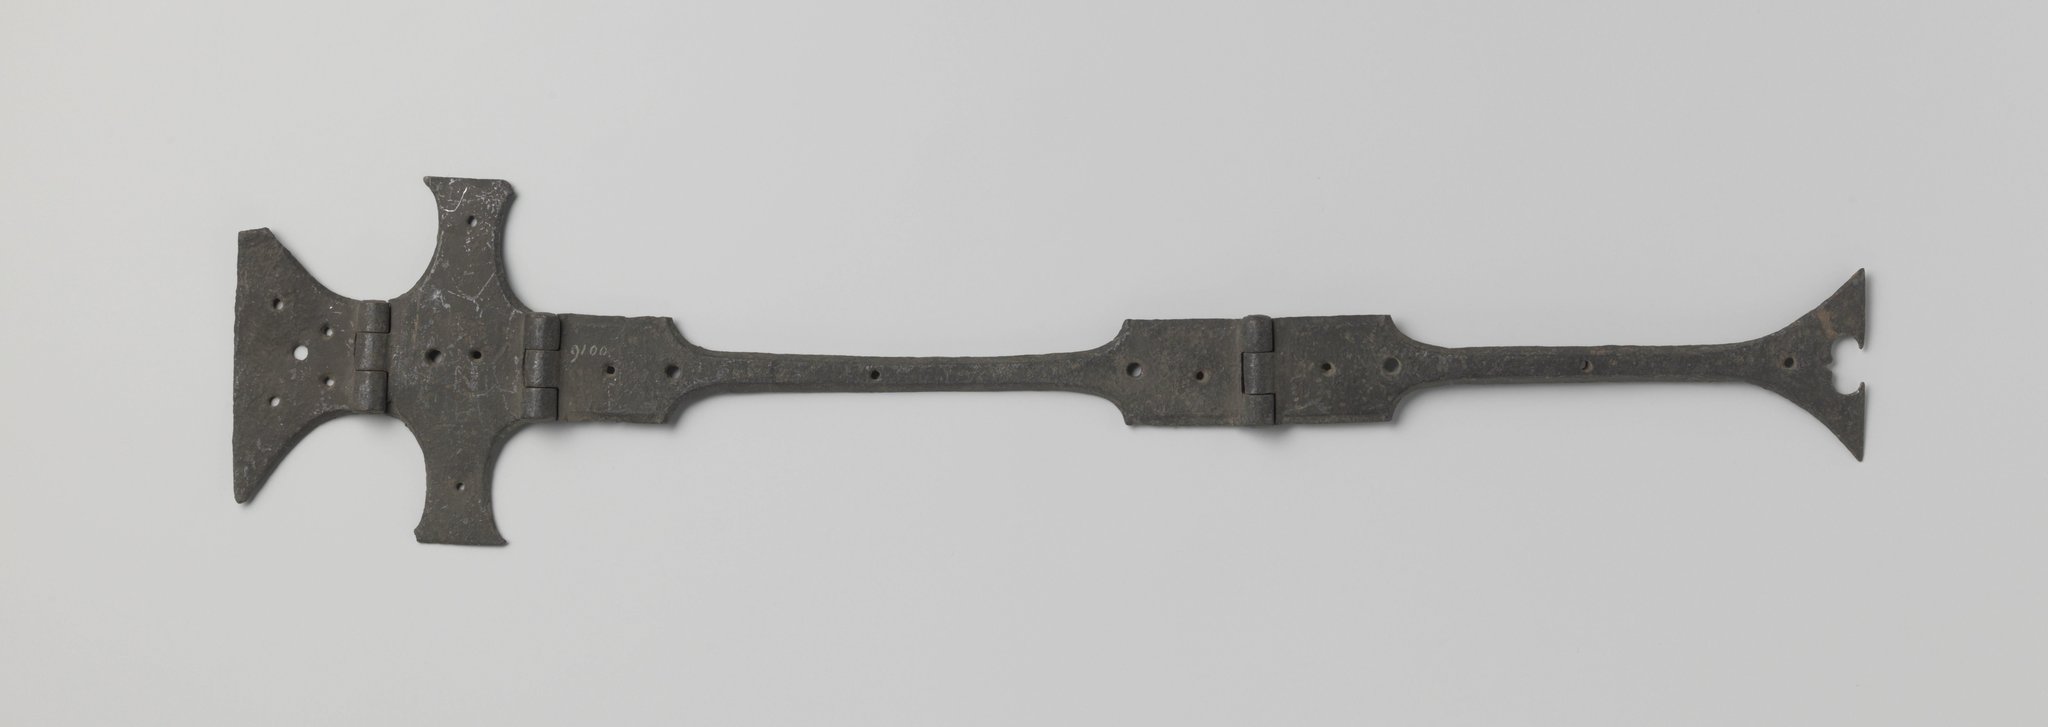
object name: hengsel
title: Hengsel van vertind ijzer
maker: Anonymous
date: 1600-1800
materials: iron, tin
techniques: chisel